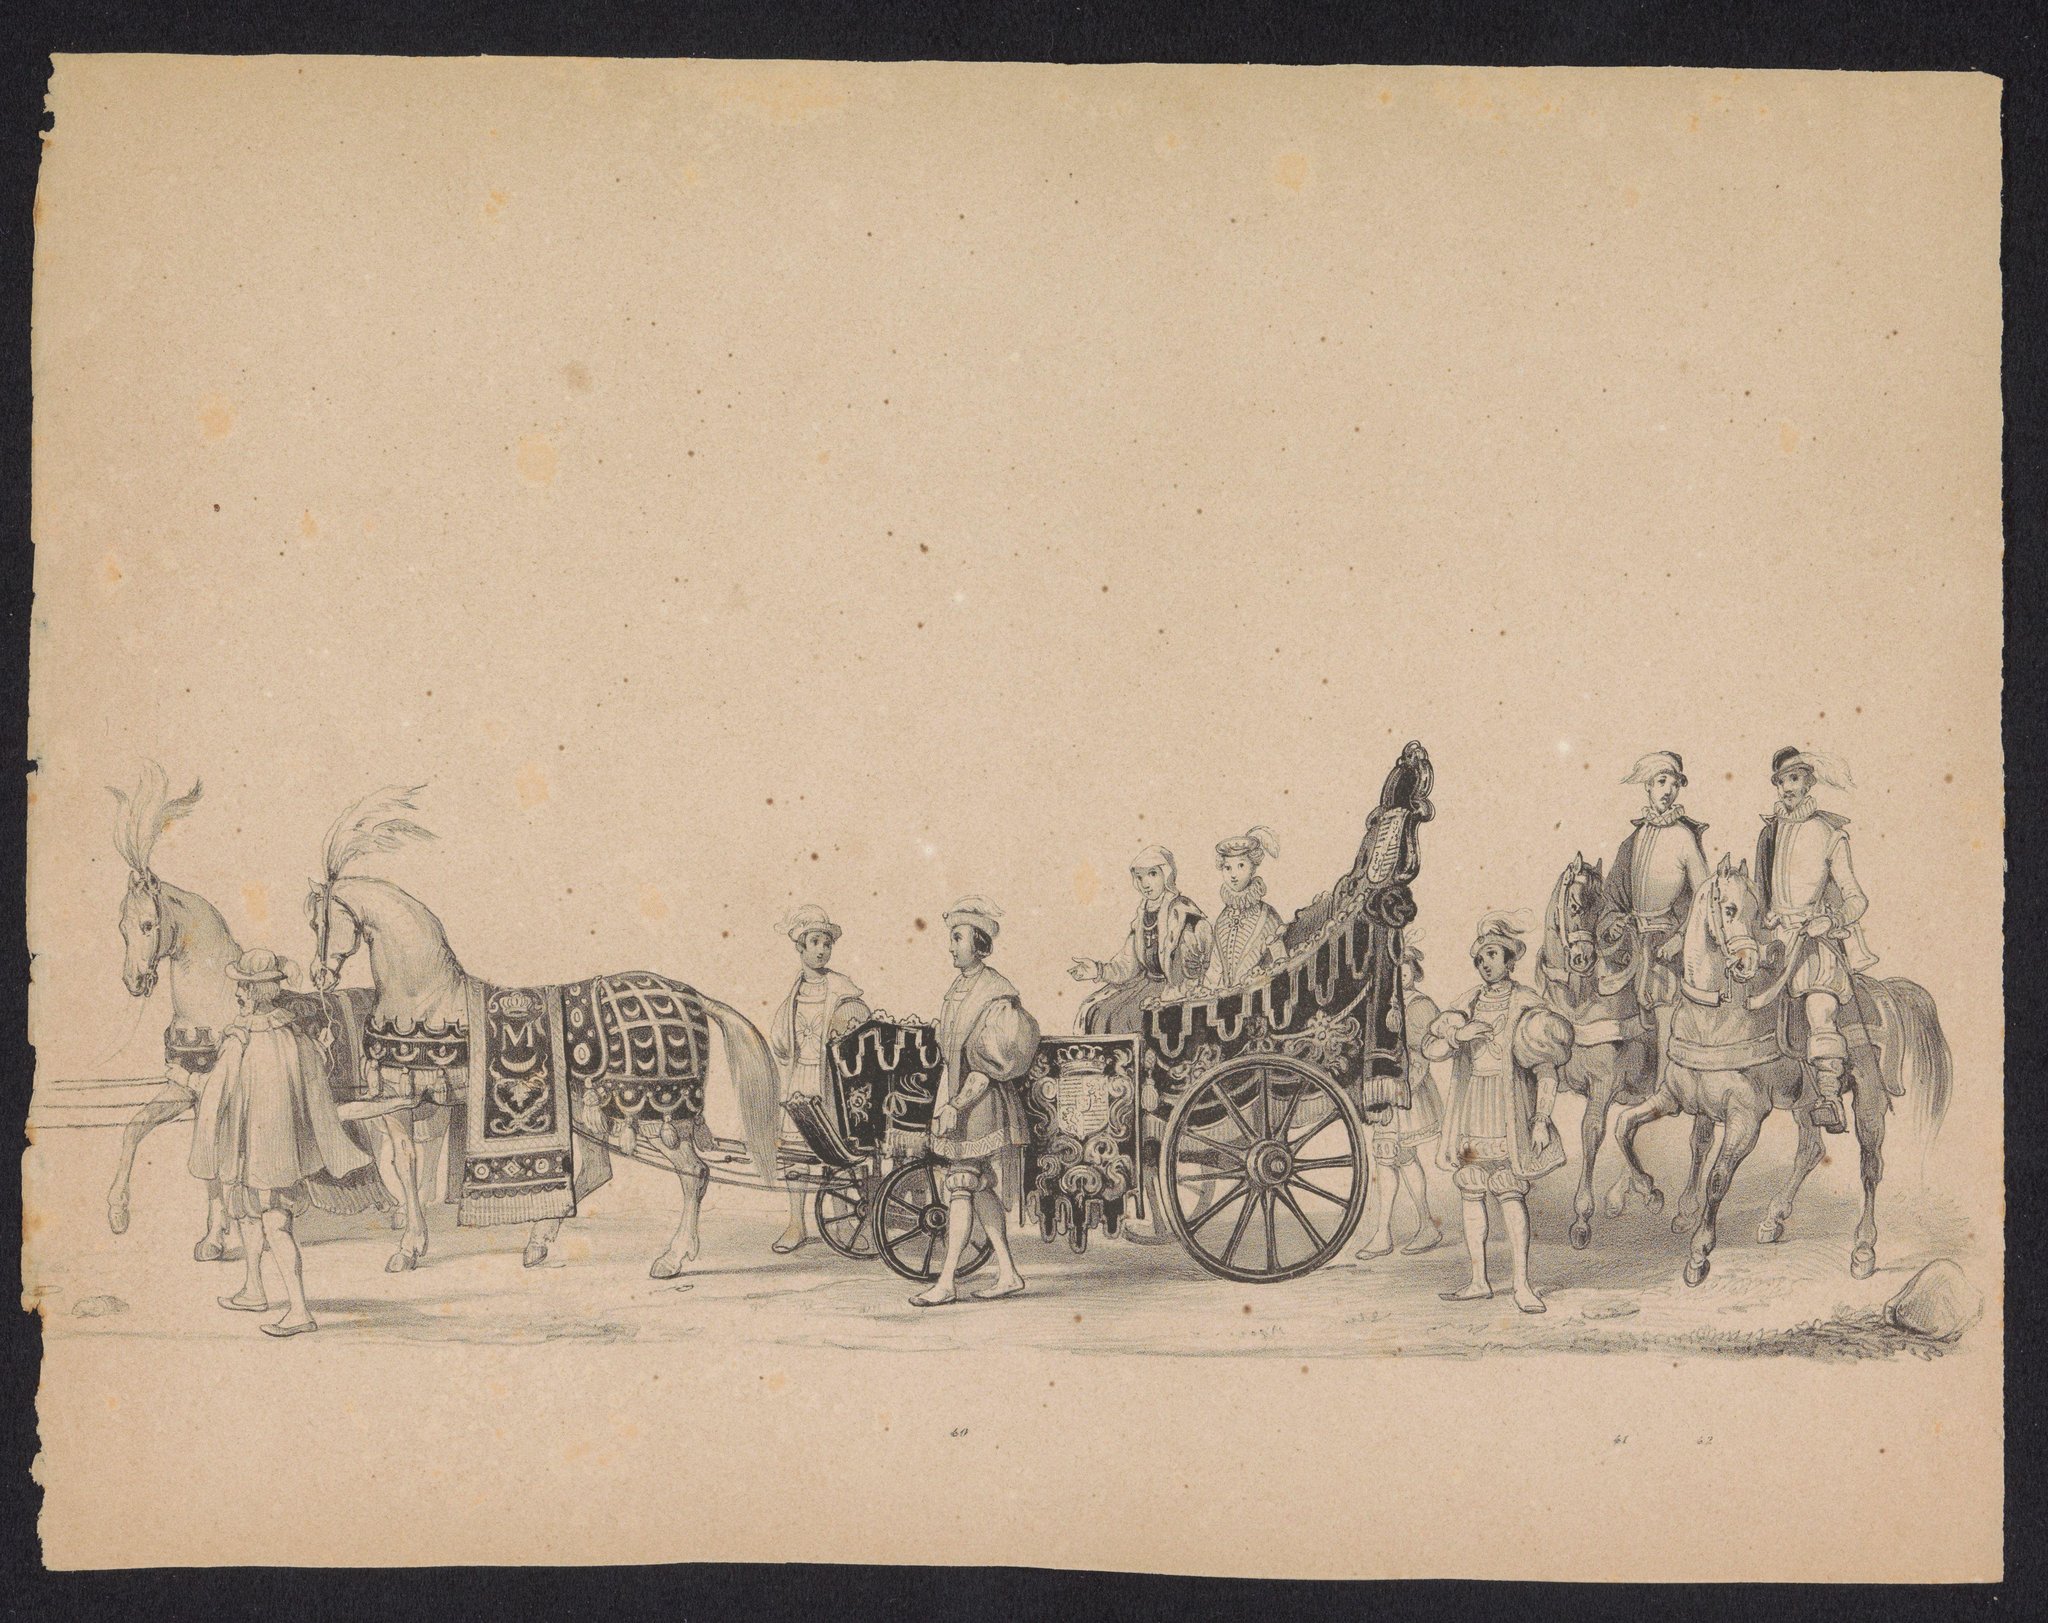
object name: print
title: Maskerade van de Utrechtse studenten, 1846 (plaat 8)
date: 1847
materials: paper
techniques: lithograph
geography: netherlands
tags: philip ii of spain, students' pageant, costumes used in pageants, utrecht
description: Historische gekostumeerde optocht van de studenten van de Utrechtse Hogeschool gehouden op 17 juni 1846 ter gelegenheid van het 210-jarig bestaan van de Hogeschool. De optocht verbeeldt de intocht van Filips II in Utrecht op 3 oktober 1549. Plaat met de groepen genummerd 40-42. Onderdeel van de serie van 22 aanelkaar te plakken losse bladen.